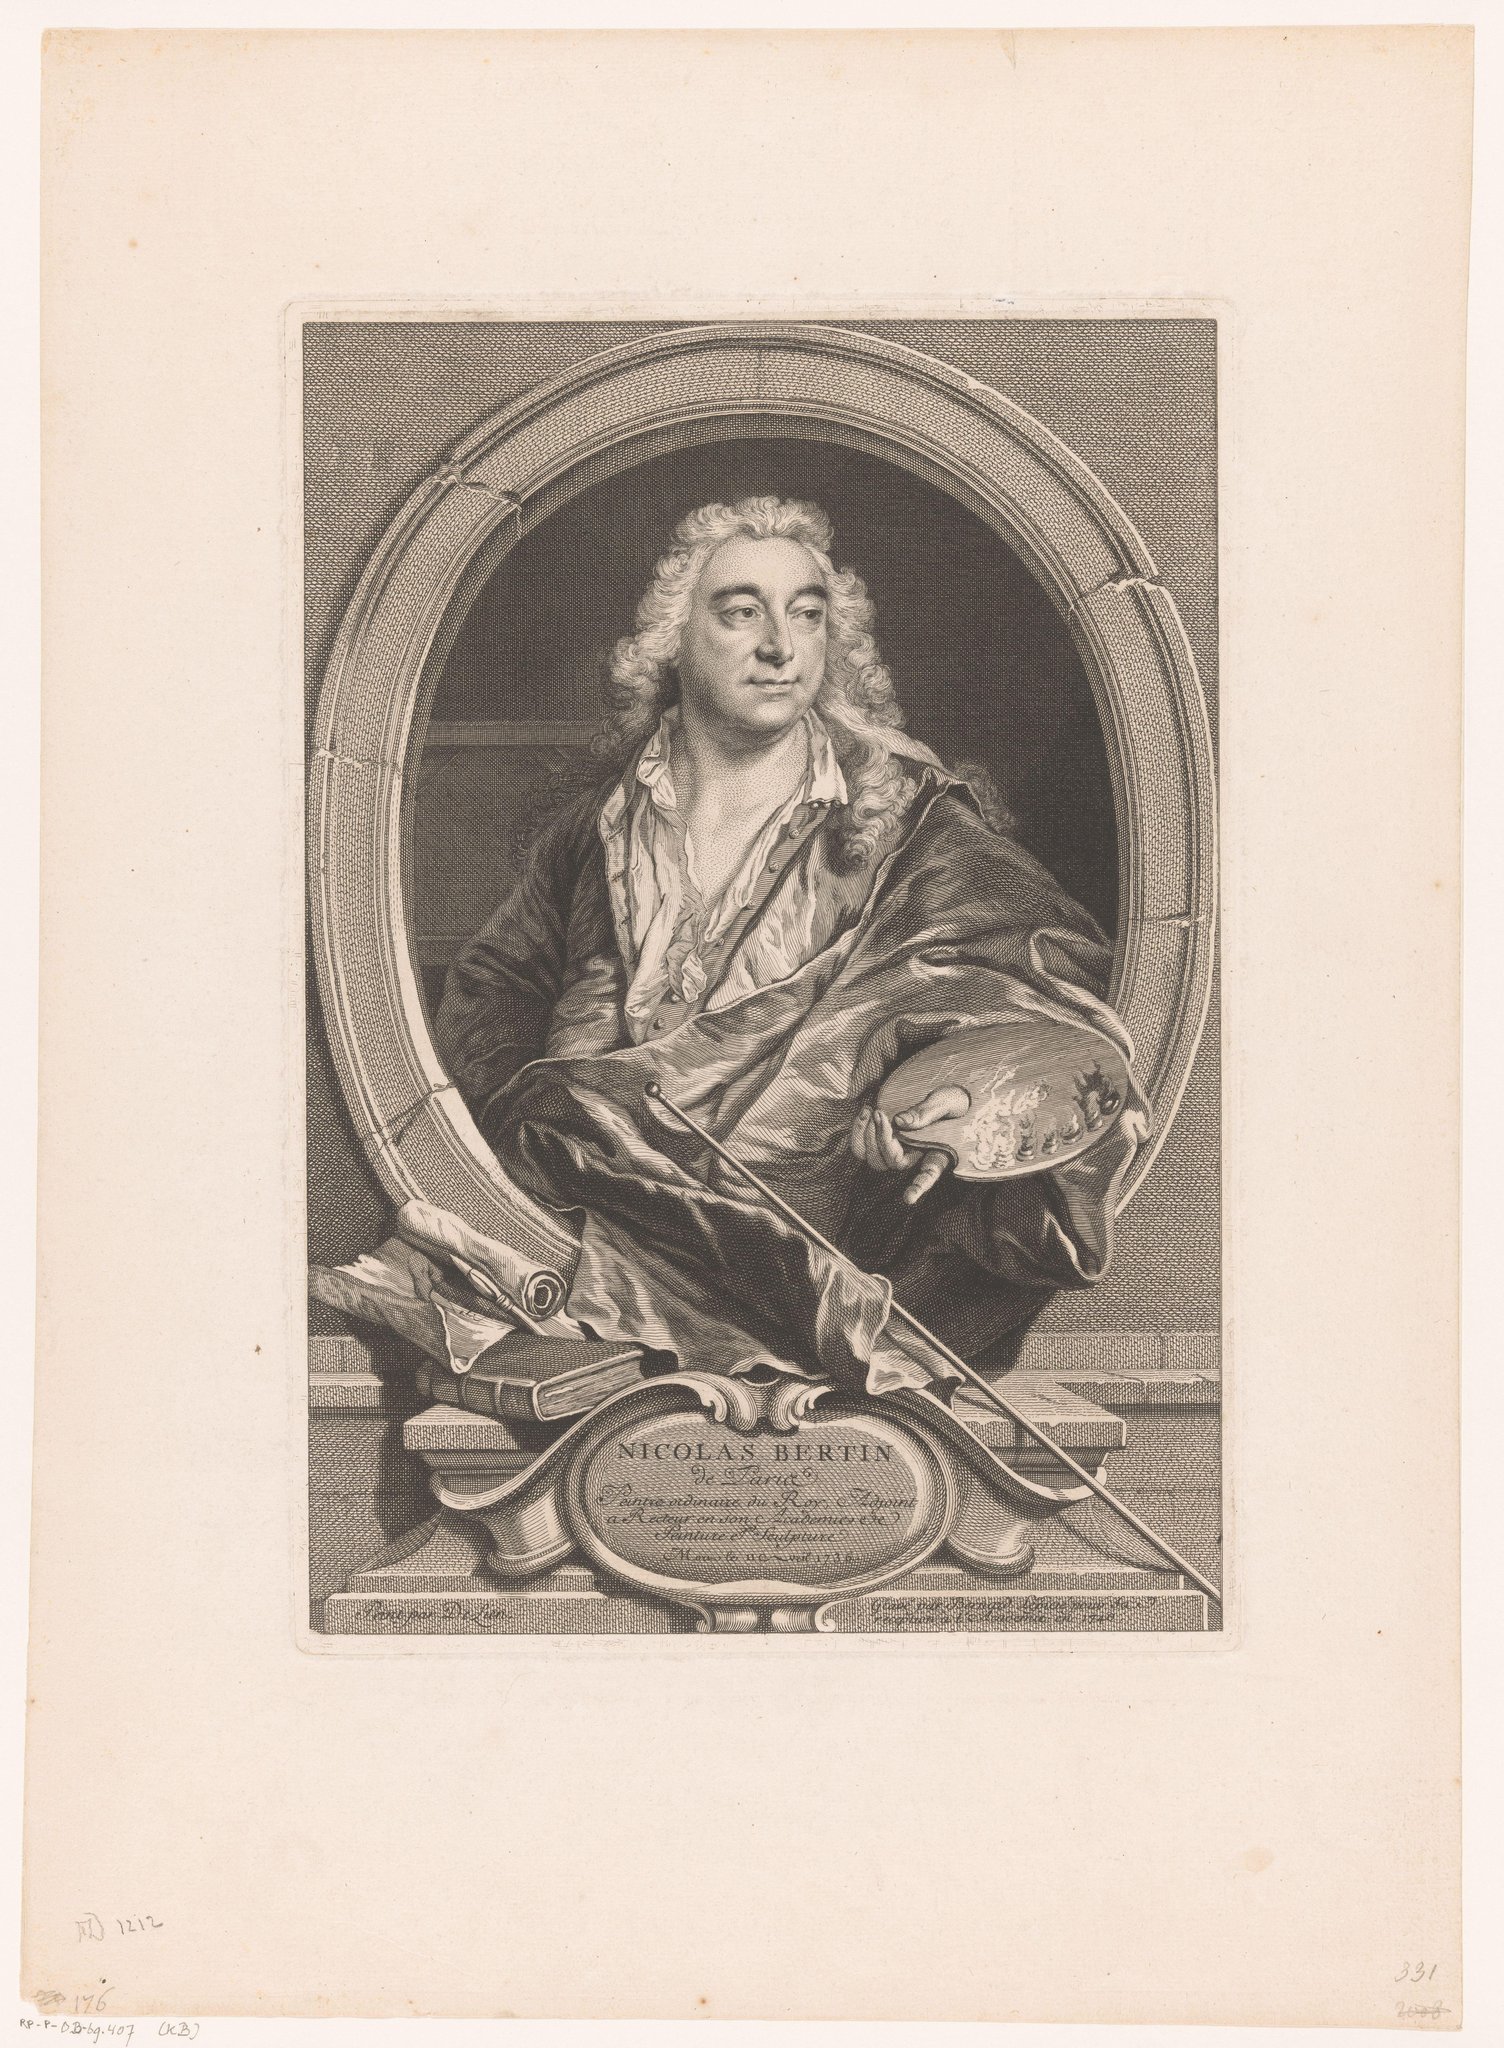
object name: print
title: Portret van Nicolas Bertin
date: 1740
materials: paper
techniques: engraving, etching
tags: paris, painter, nicolas bertin, historical persons, portrait, self-portrait of painter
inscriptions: collector's mark: Lugt 240